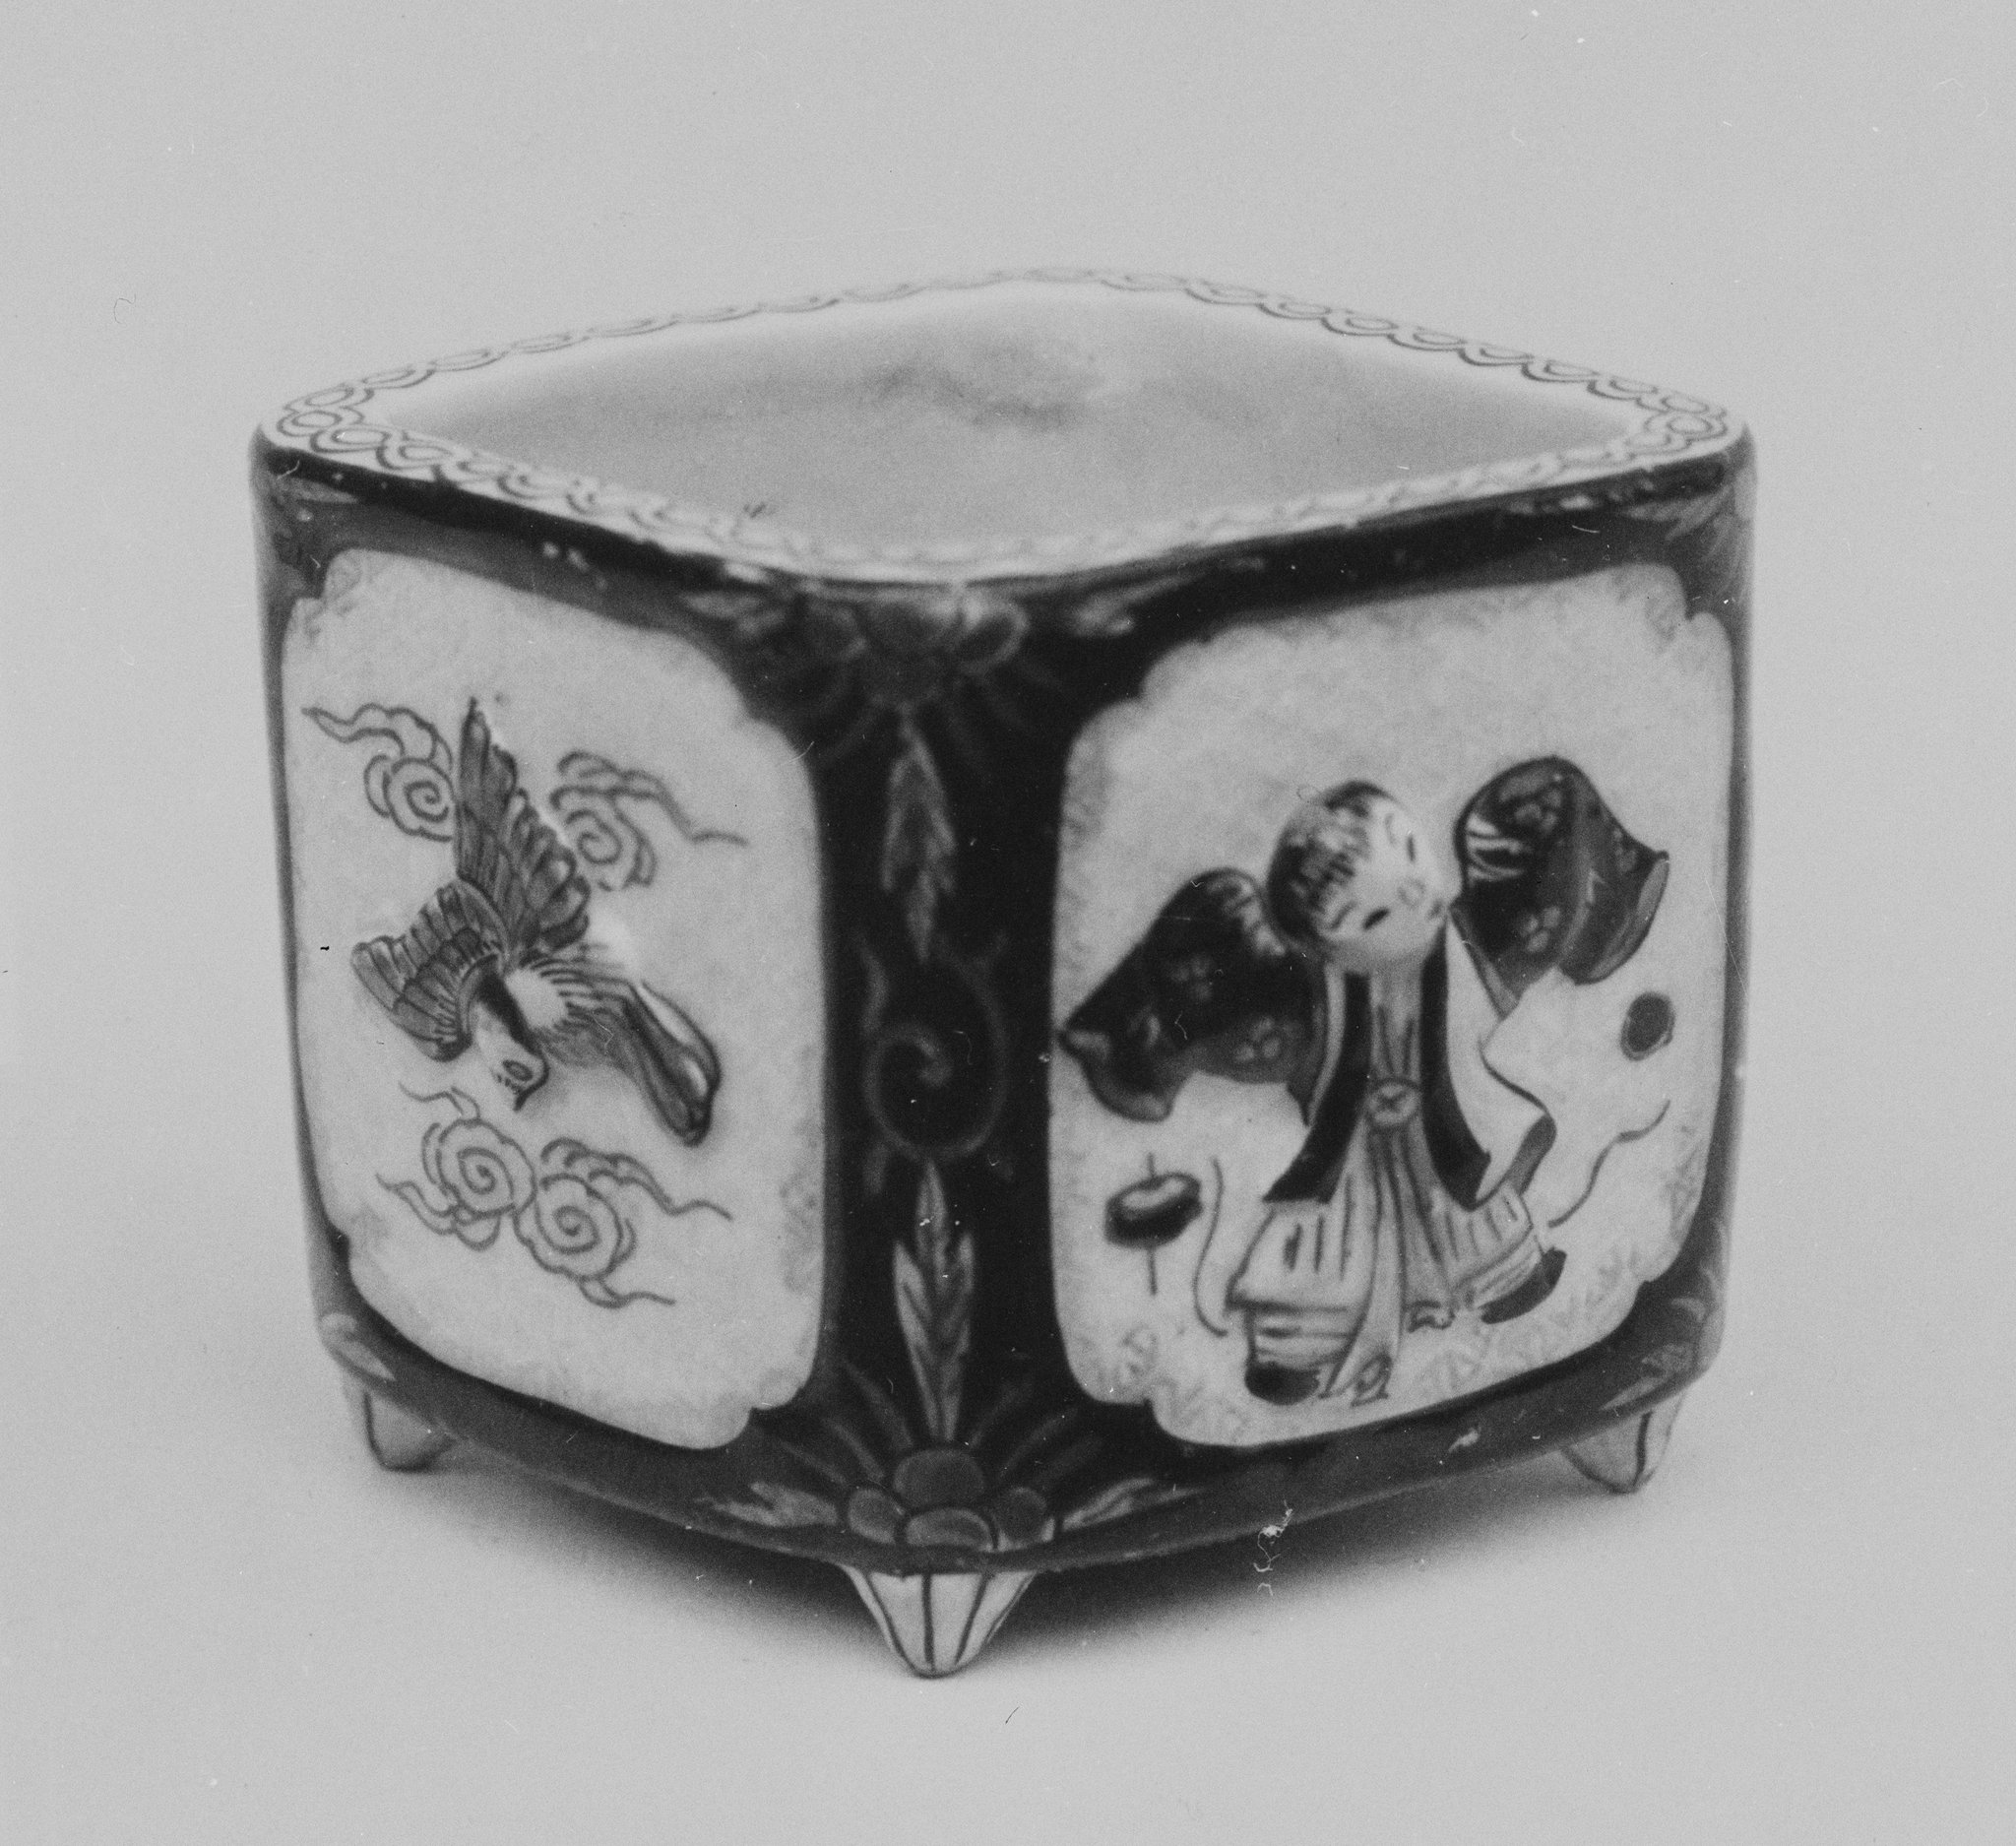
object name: censer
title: Censer Decorated with Figures within Scrolls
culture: japanese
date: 1830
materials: enamel, porcelain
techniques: relief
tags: birds,boys,censers